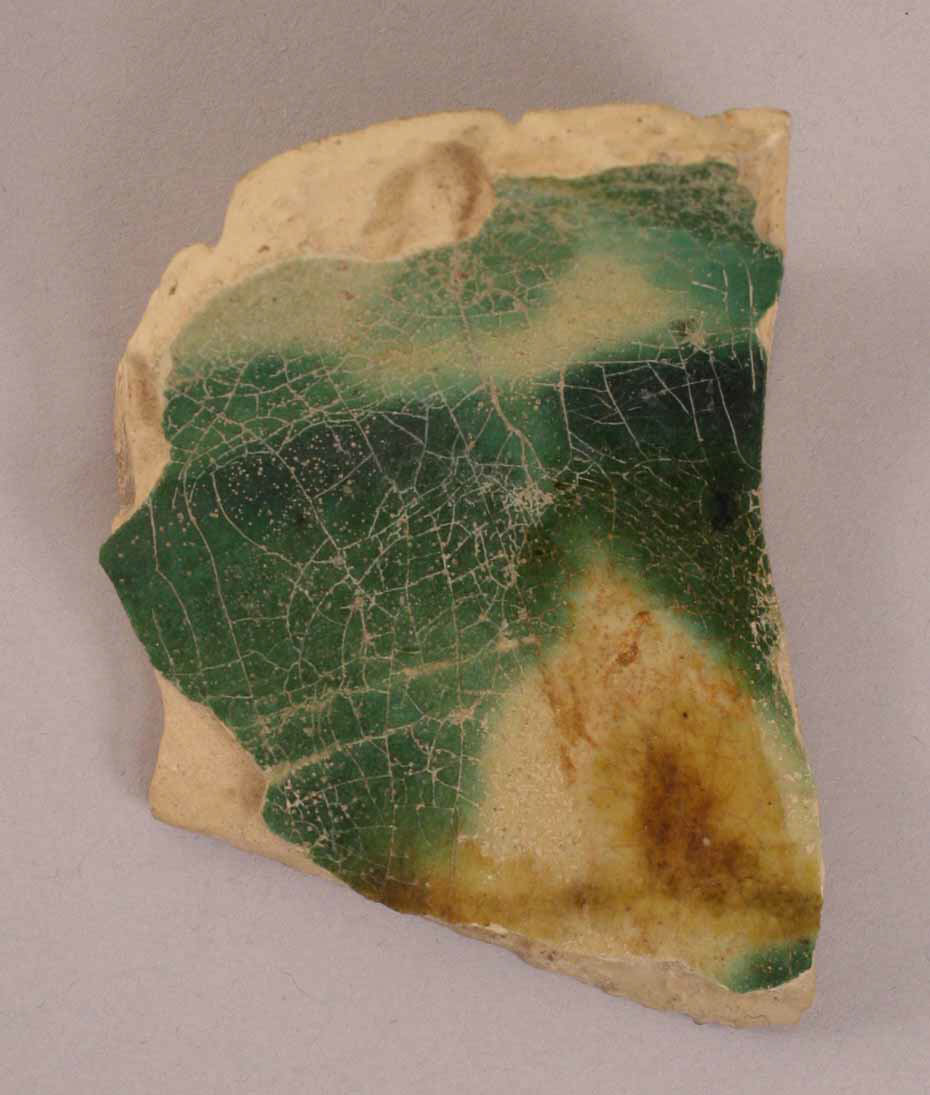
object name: fragment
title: Ceramic Fragment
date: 867-1000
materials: earthenware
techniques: glazing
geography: saudi arabia